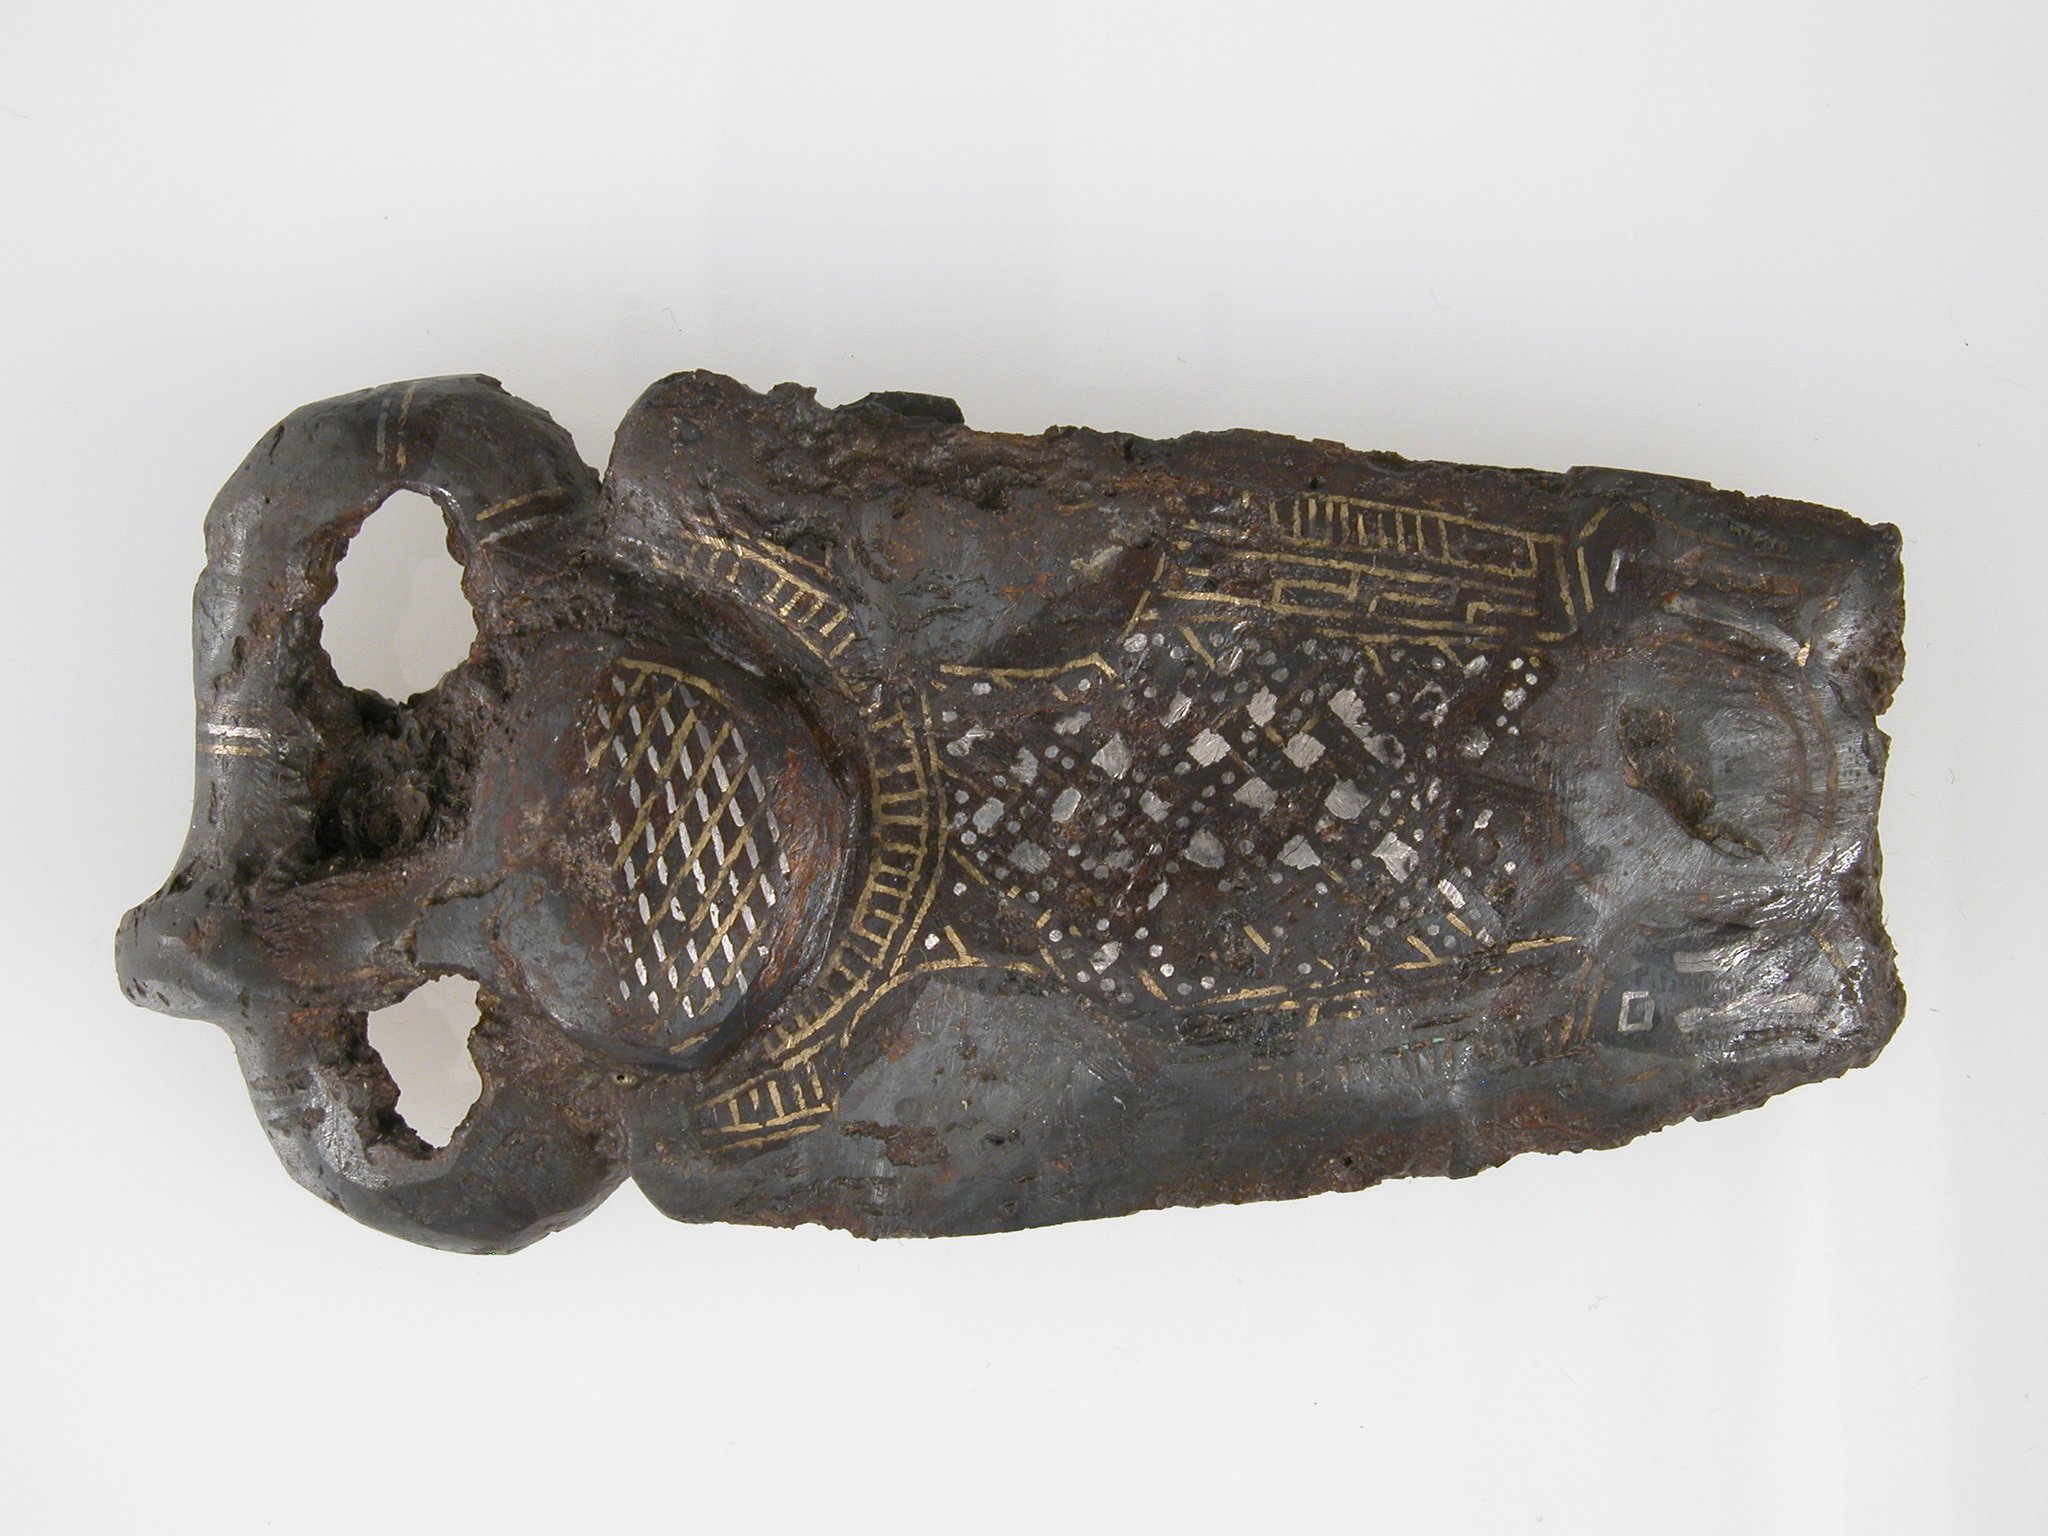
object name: belt buckle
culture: frankish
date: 501-700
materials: brass, iron, silver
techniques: inlay